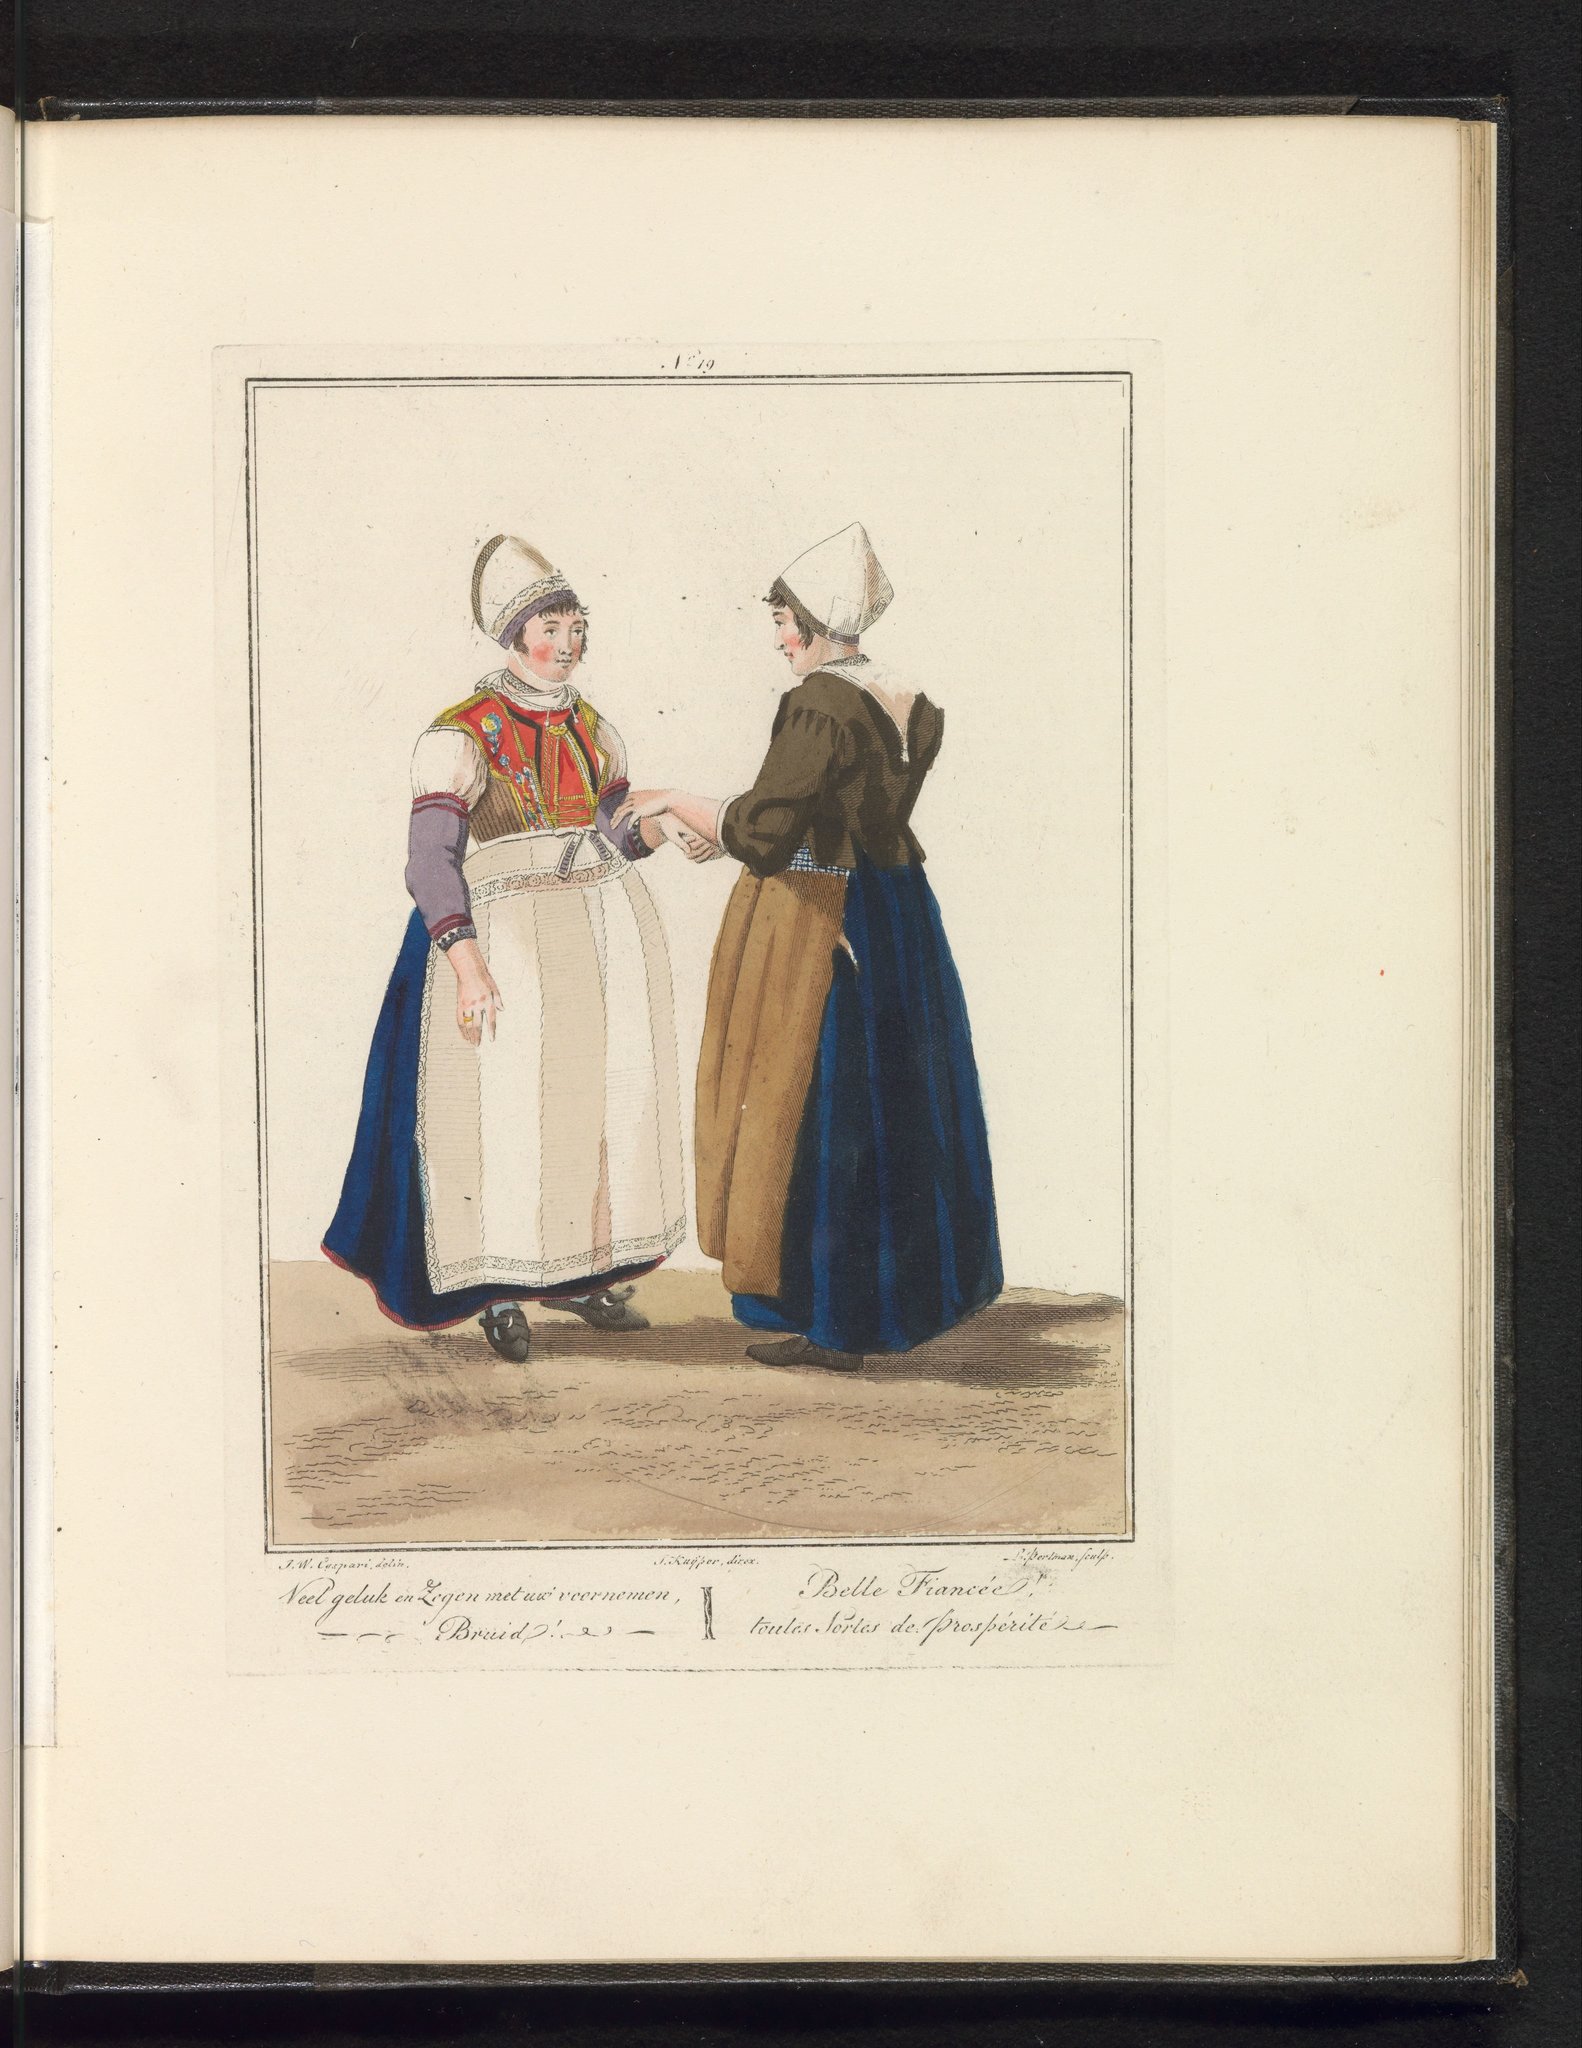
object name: print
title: Veel geluk en Zegen met uw' voornemen, Bruid! / Belle Fiancée! toutes Sortes de prospérité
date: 1807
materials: paper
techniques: etching, hand coloring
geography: netherlands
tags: folk costume, regional costume, clothes, costume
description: Gebruikt als illustratie in: Evert Maaskamp, Afbeeldingen van de kleedingen, zeden en gewoonten in de noordelijke provincien van het Koningrijk der Nederlanden, met den aanvang der negentiende eeuw = Tableaux des habillemens, mœurs et coutumes dans les provinces septentrionales du Royaume des Pays-Bas, au commencement du dix-neuvième siècle. Amsterdam: Evert Maaskamp, 1829 [heruitgave van de oorspronkelijke platen eerst verschenen in 1803-1807].